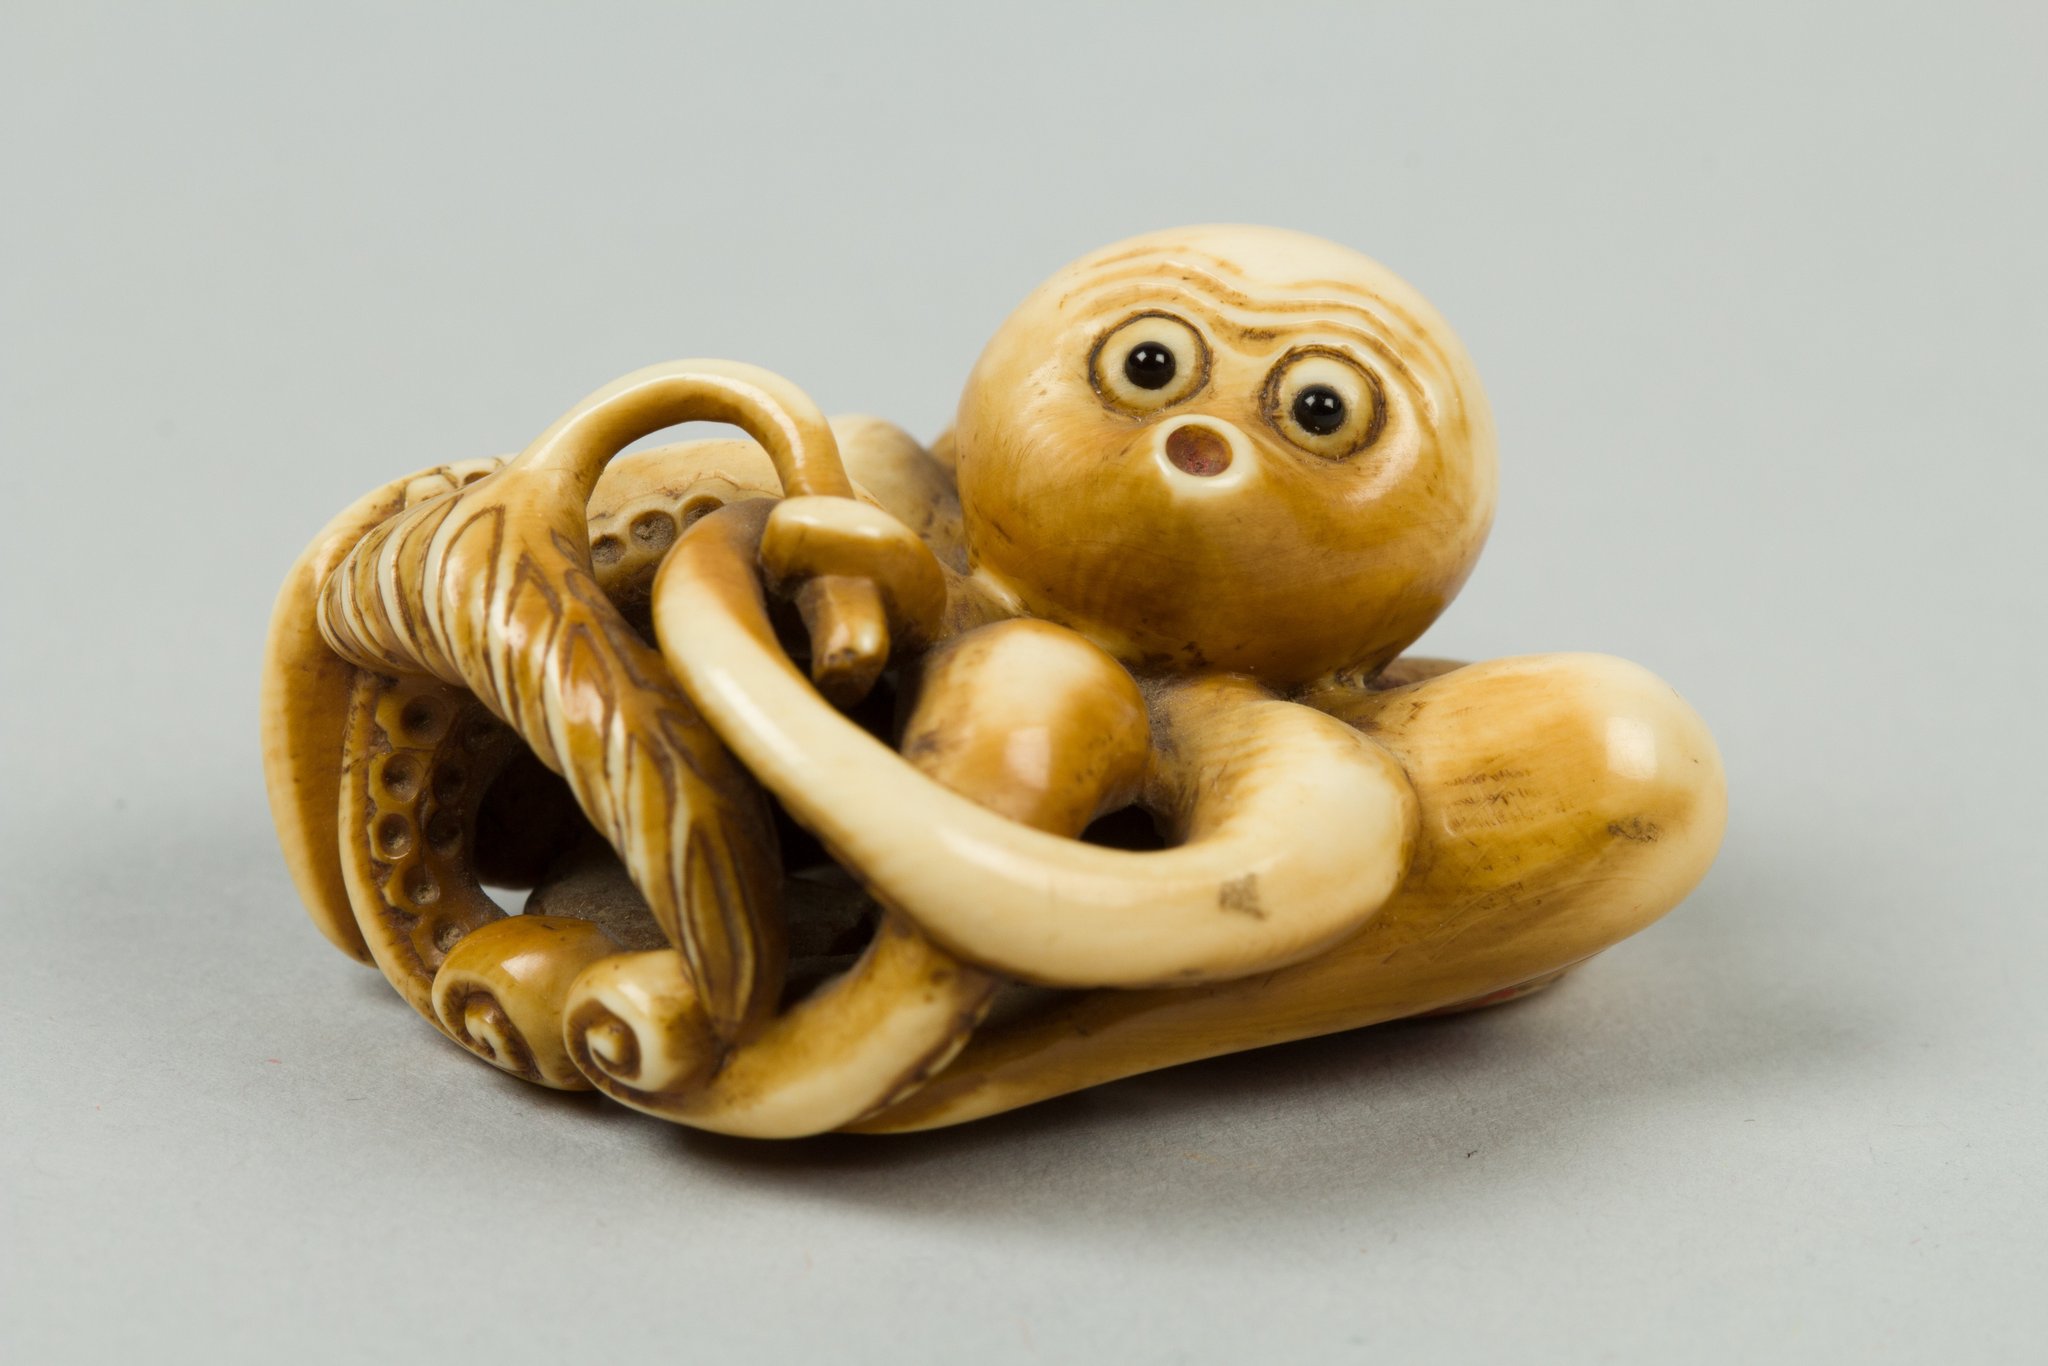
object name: netsuke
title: Netsuke of Octopus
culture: japanese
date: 1801-1900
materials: ivory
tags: octopus